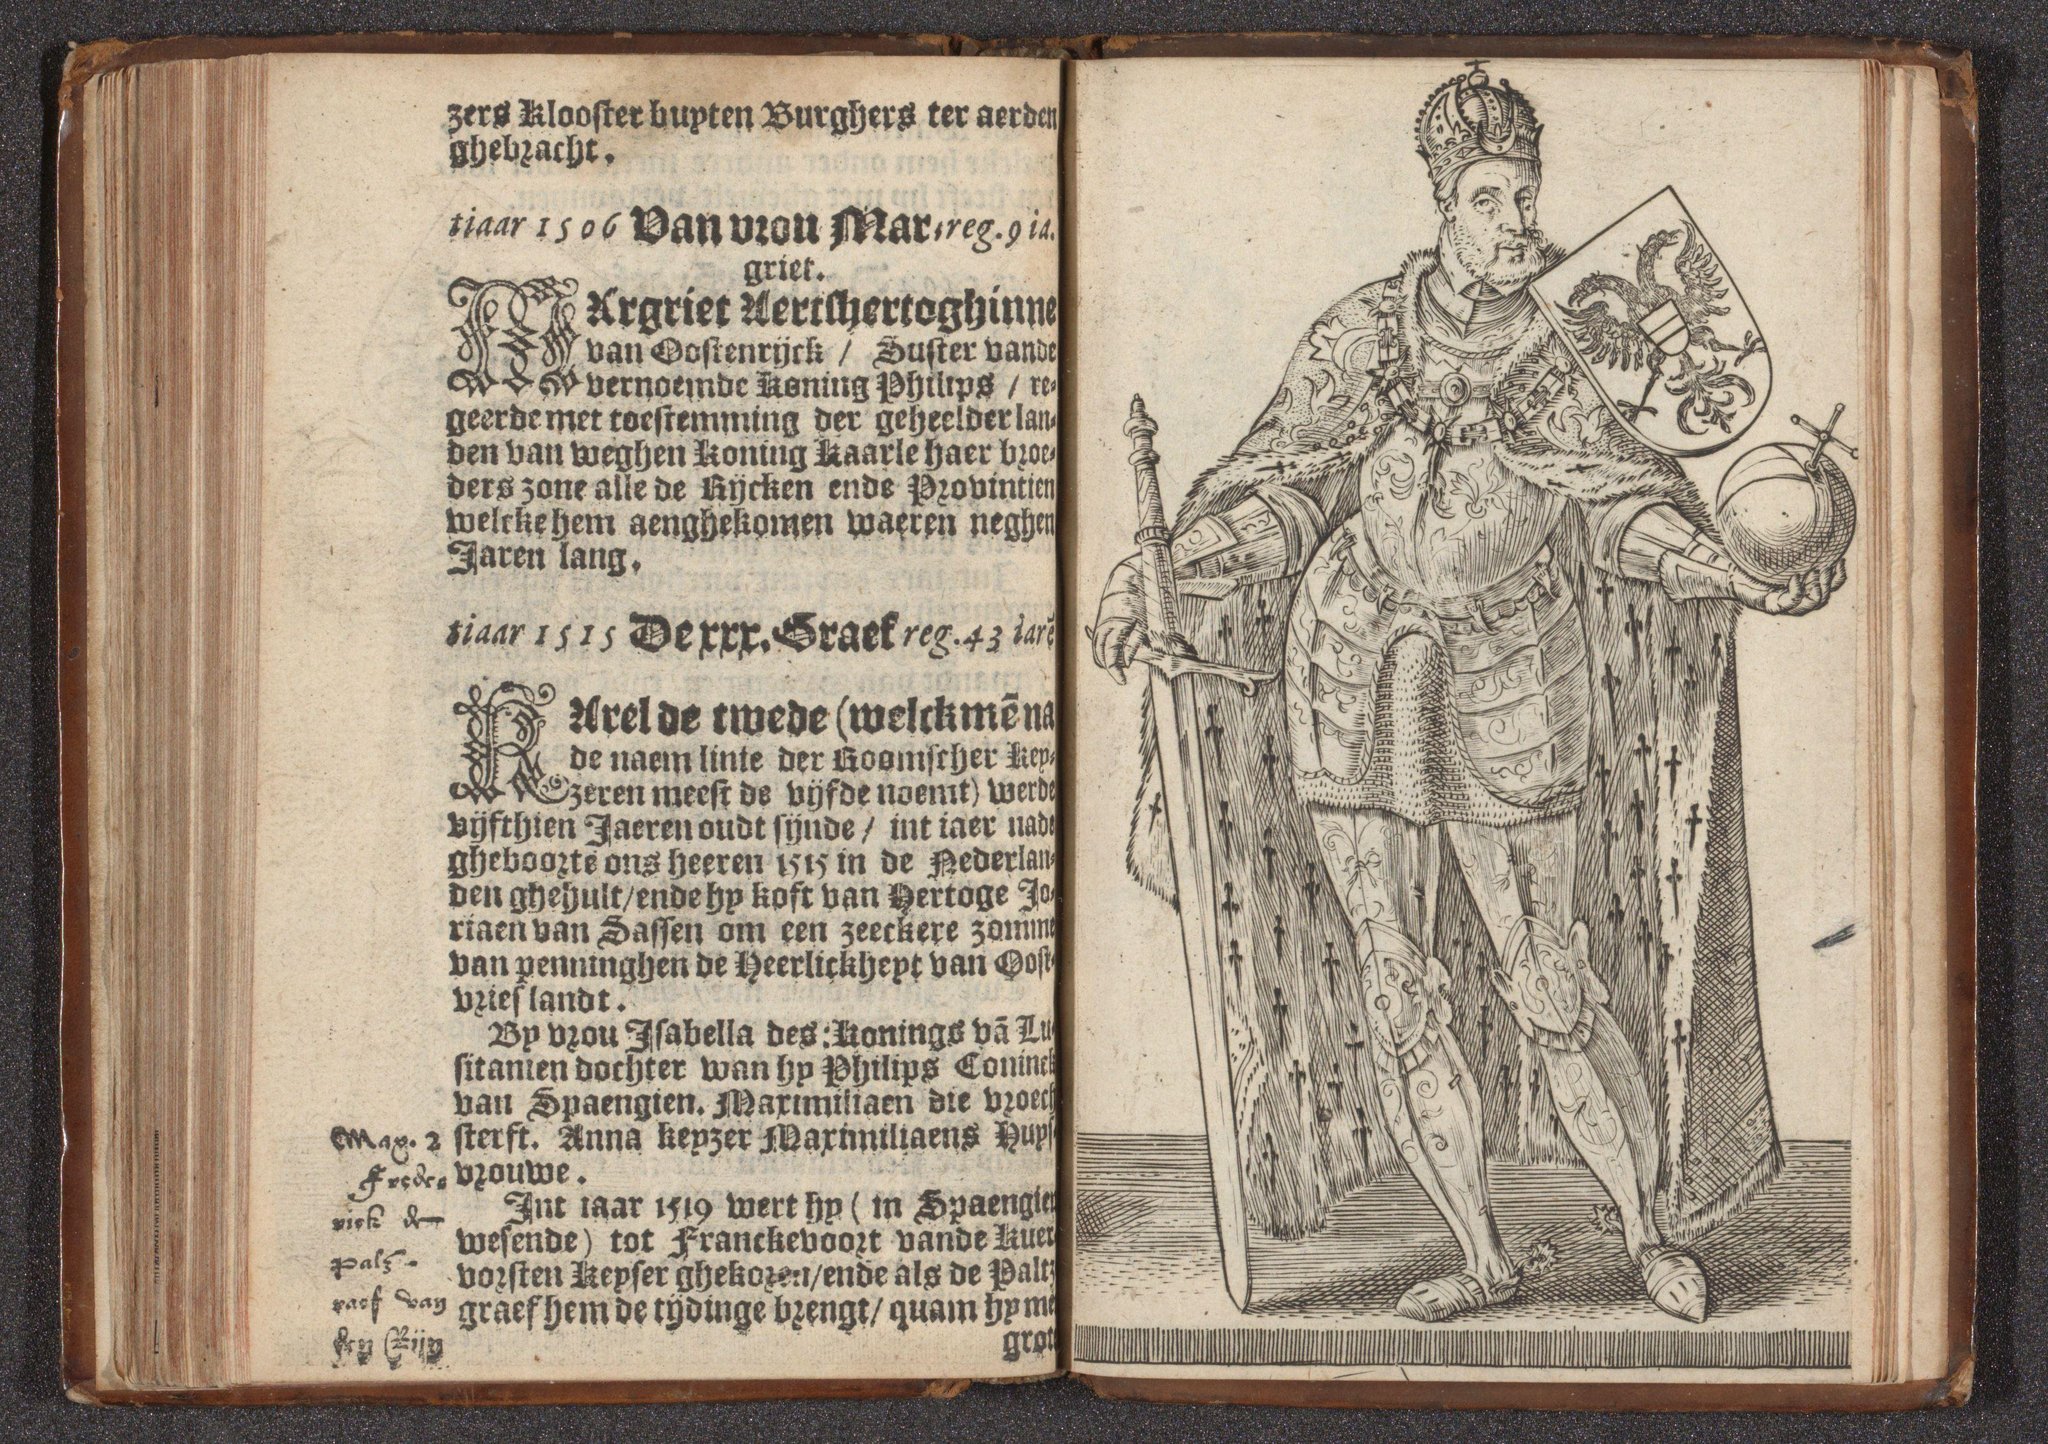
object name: album leaf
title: Portret van keizer Karel V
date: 1586-1587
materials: paper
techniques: engraving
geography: amsterdam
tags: charles v (holy roman emperor and king of spain), historical persons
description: Karel V, ten voeten uit, met keizerskroon, rijksappel, zwaard en wapenschild met dubbelkoppige adelaar. De prent maakt deel uit van een boek met beschrijvingen en voorstellingen van de graven van Holland, Zeeland en Friesland.